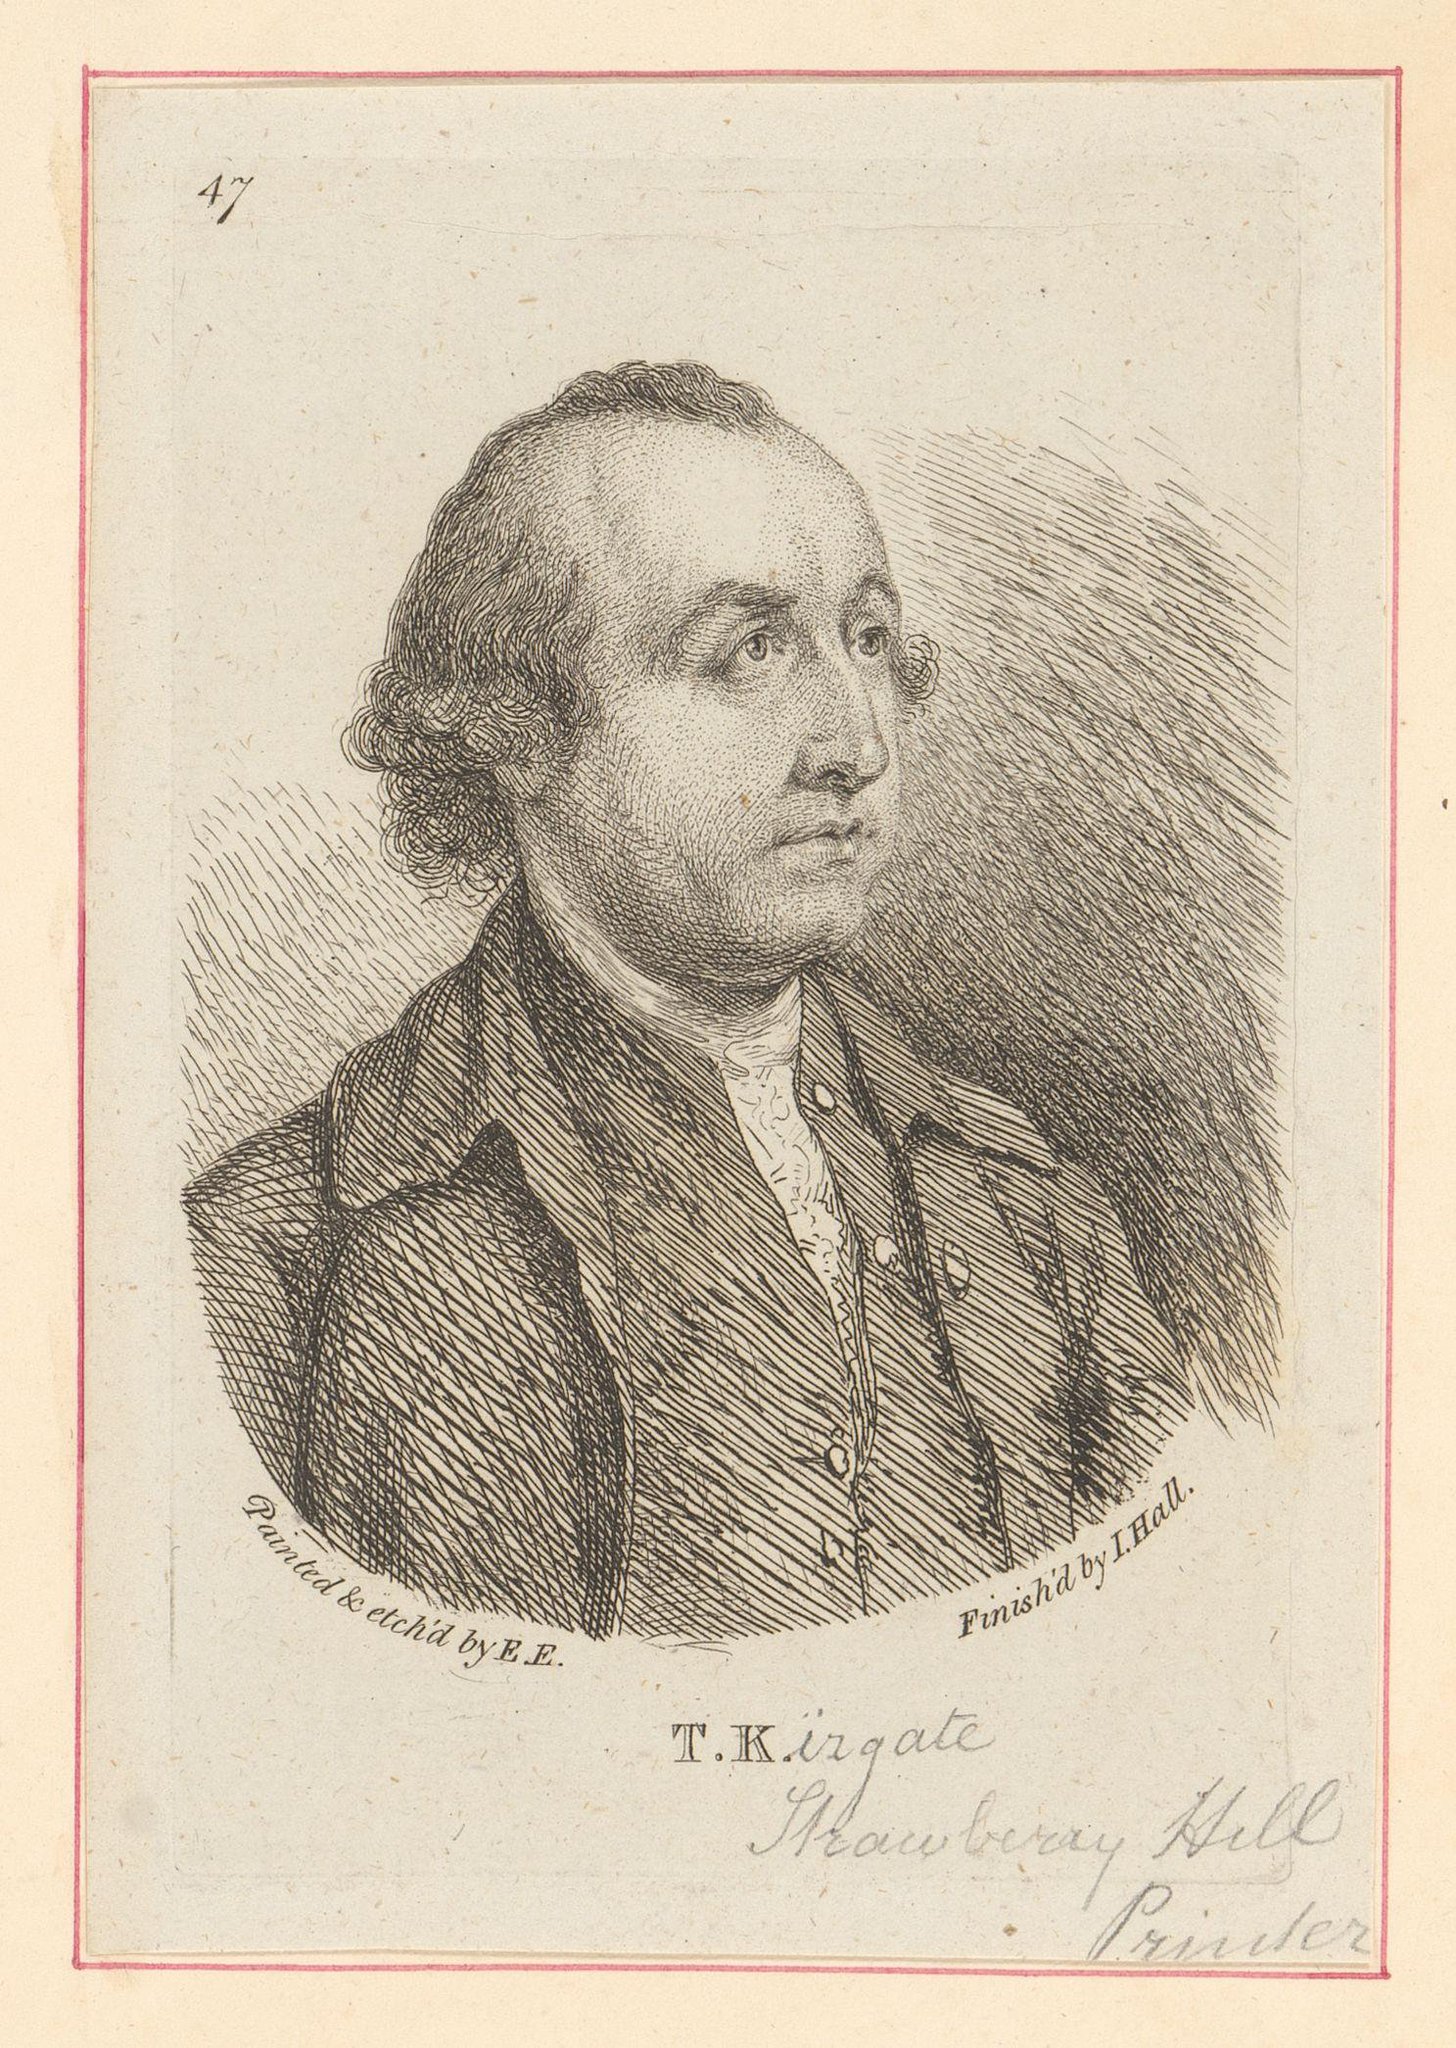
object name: album leaf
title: Etchings by E. Edwards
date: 1747-1797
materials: paper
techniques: etching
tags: thomas kirgate, historical persons, publishing, publisher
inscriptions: inscription: ‘Kirgate/ Strawberry Hill/ Printer’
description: Prent maakt deel uit van een serie van 51 prenten, bestaande uit twee delen met landschappen (36 prenten) en figuren en portretten (15 prenten), voor het eerst uitgegeven in Londen in 1790.